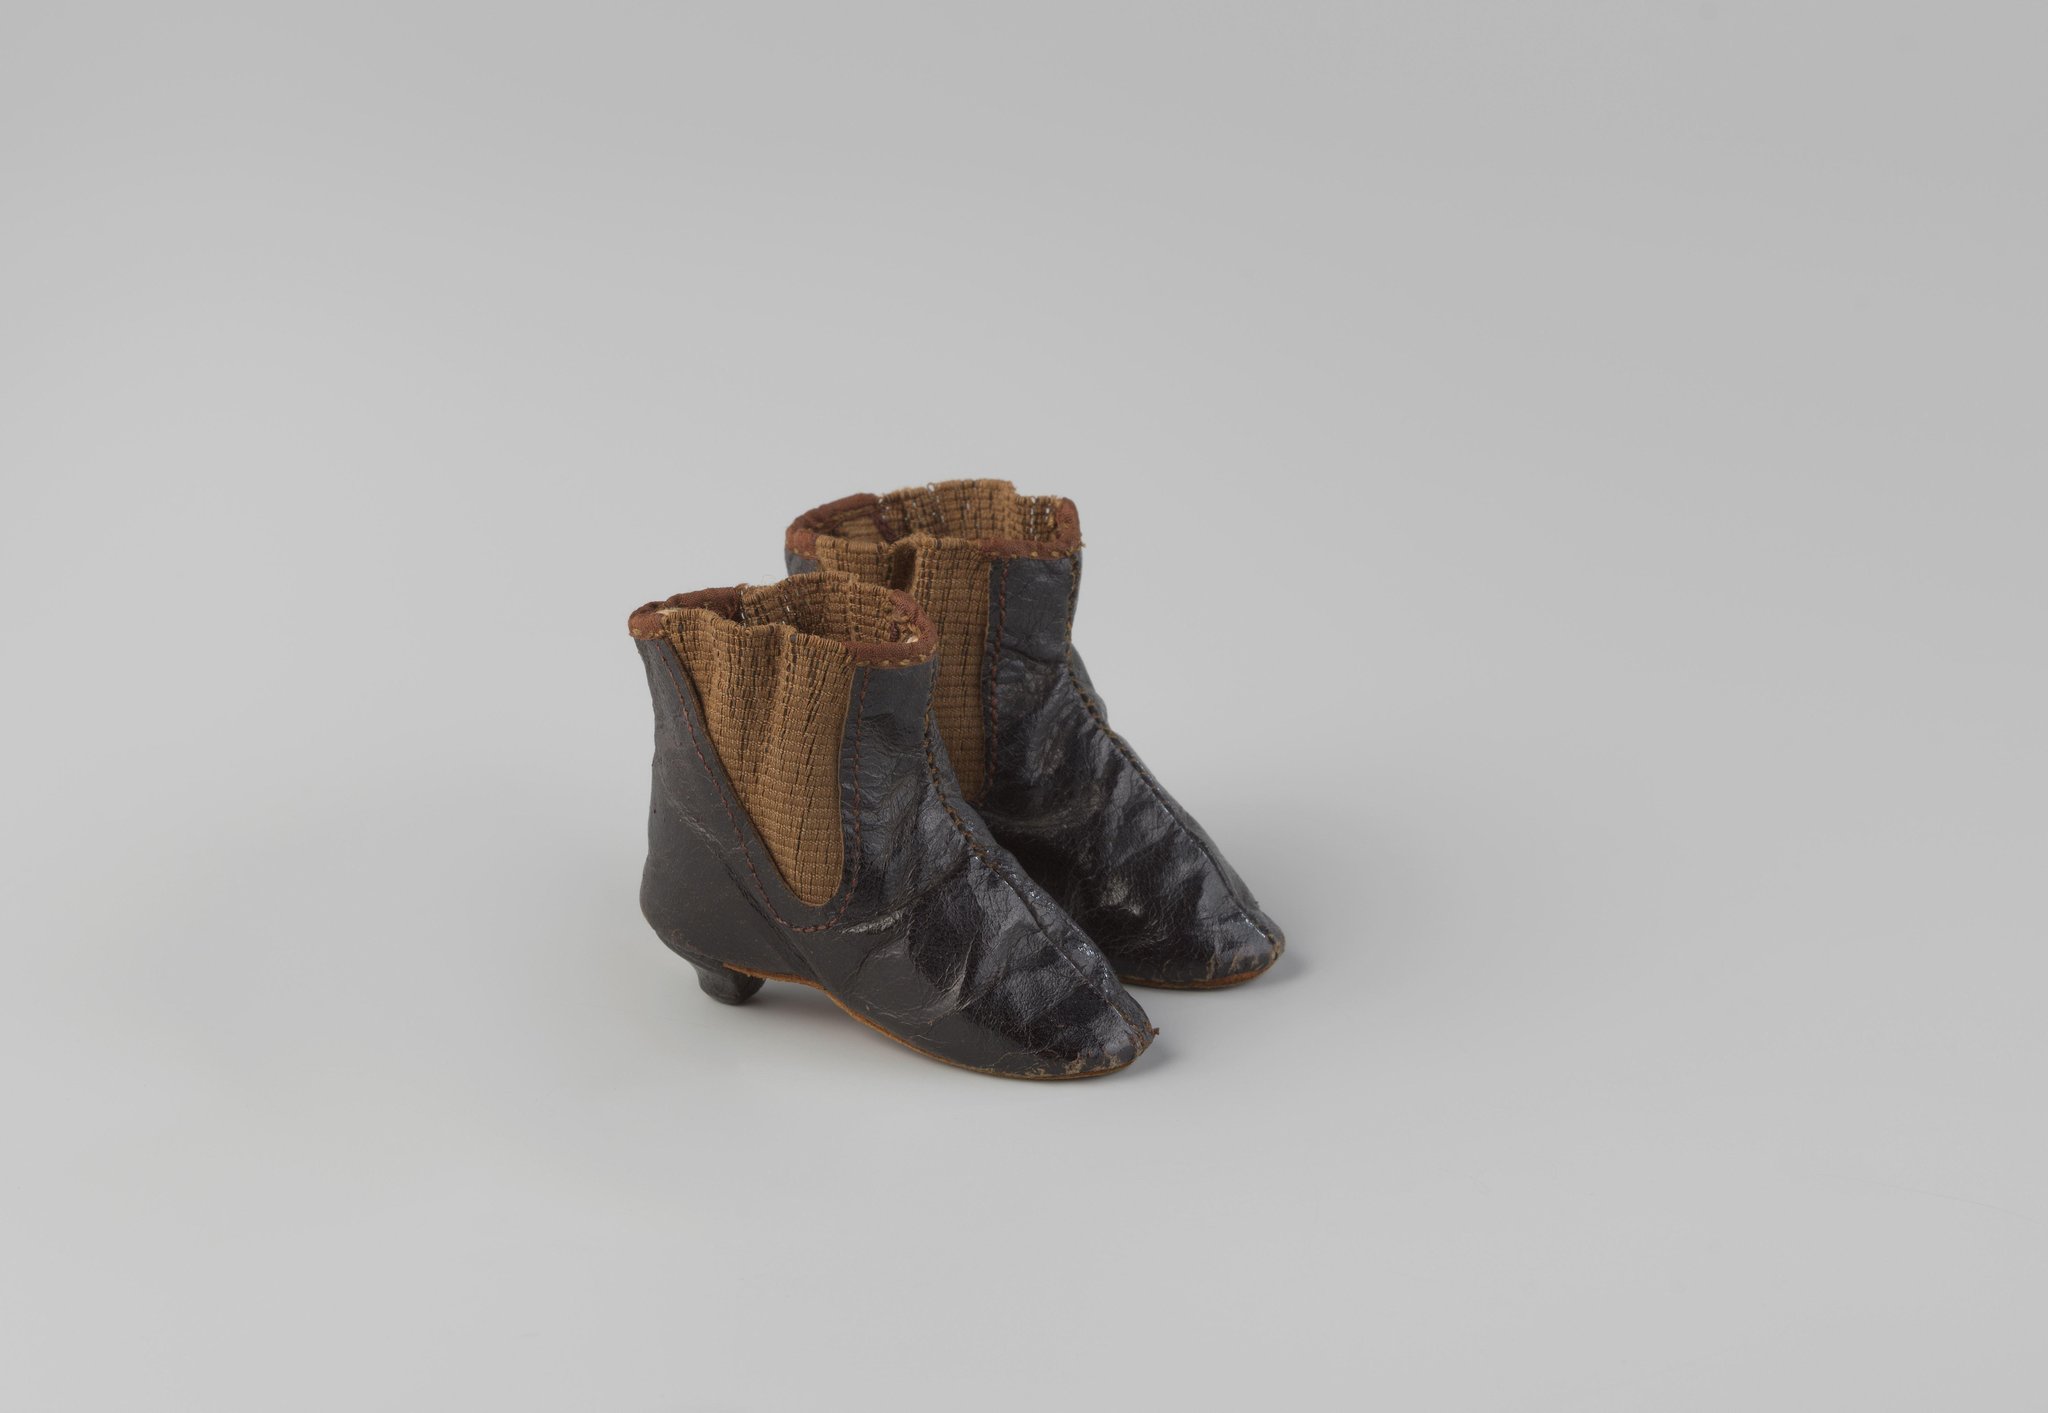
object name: doll's clothing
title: Paar goudleren laarzen met bruin elastiek en hoge hak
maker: Anonymous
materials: leather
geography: netherlands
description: Paar goudleren laarzen met bruin elastiek en hoge hak.